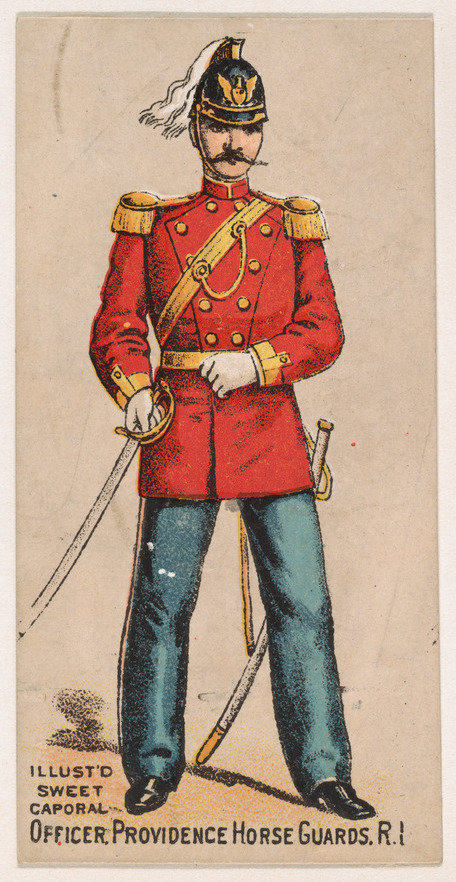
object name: print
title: Officer, Providence Horse Guards, Rhode Island, from the Military Series (N224) issued by Kinney Tobacco Company to promote Sweet Caporal Cigarettes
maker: kinney brothers tobacco company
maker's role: publisher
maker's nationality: american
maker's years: 1869-2011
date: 1888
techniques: color lithograph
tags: soldiers,swords,men